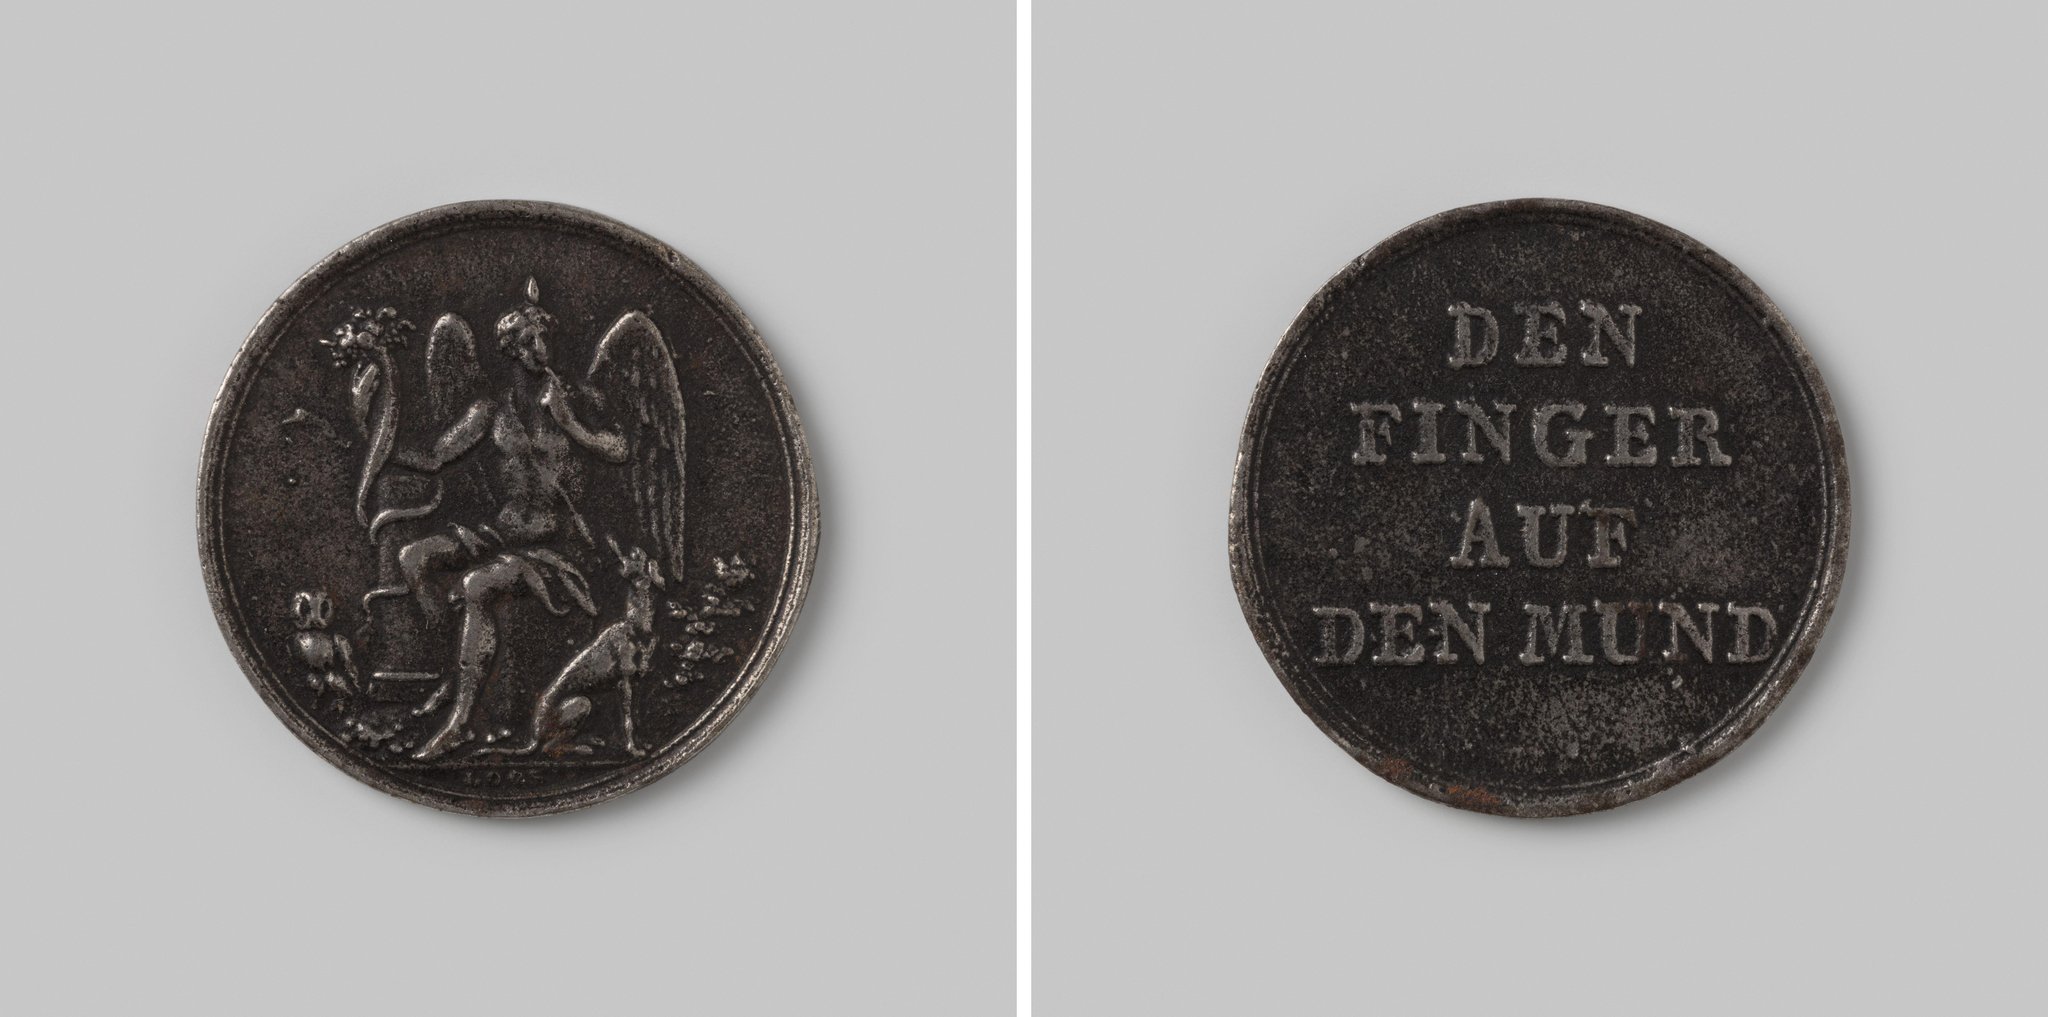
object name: history medal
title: Duitse whist-penning op de stilzwijgendheid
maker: loos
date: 1800-1850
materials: iron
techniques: striking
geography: berlin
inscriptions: inscription: ‘DEN / FINGER / AUF / DEN MUND’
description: IJzeren penning, op de voorzijde een zitende Genius bij een zuil met allerhande symbolen, op de keerzijde vier regels tekst.